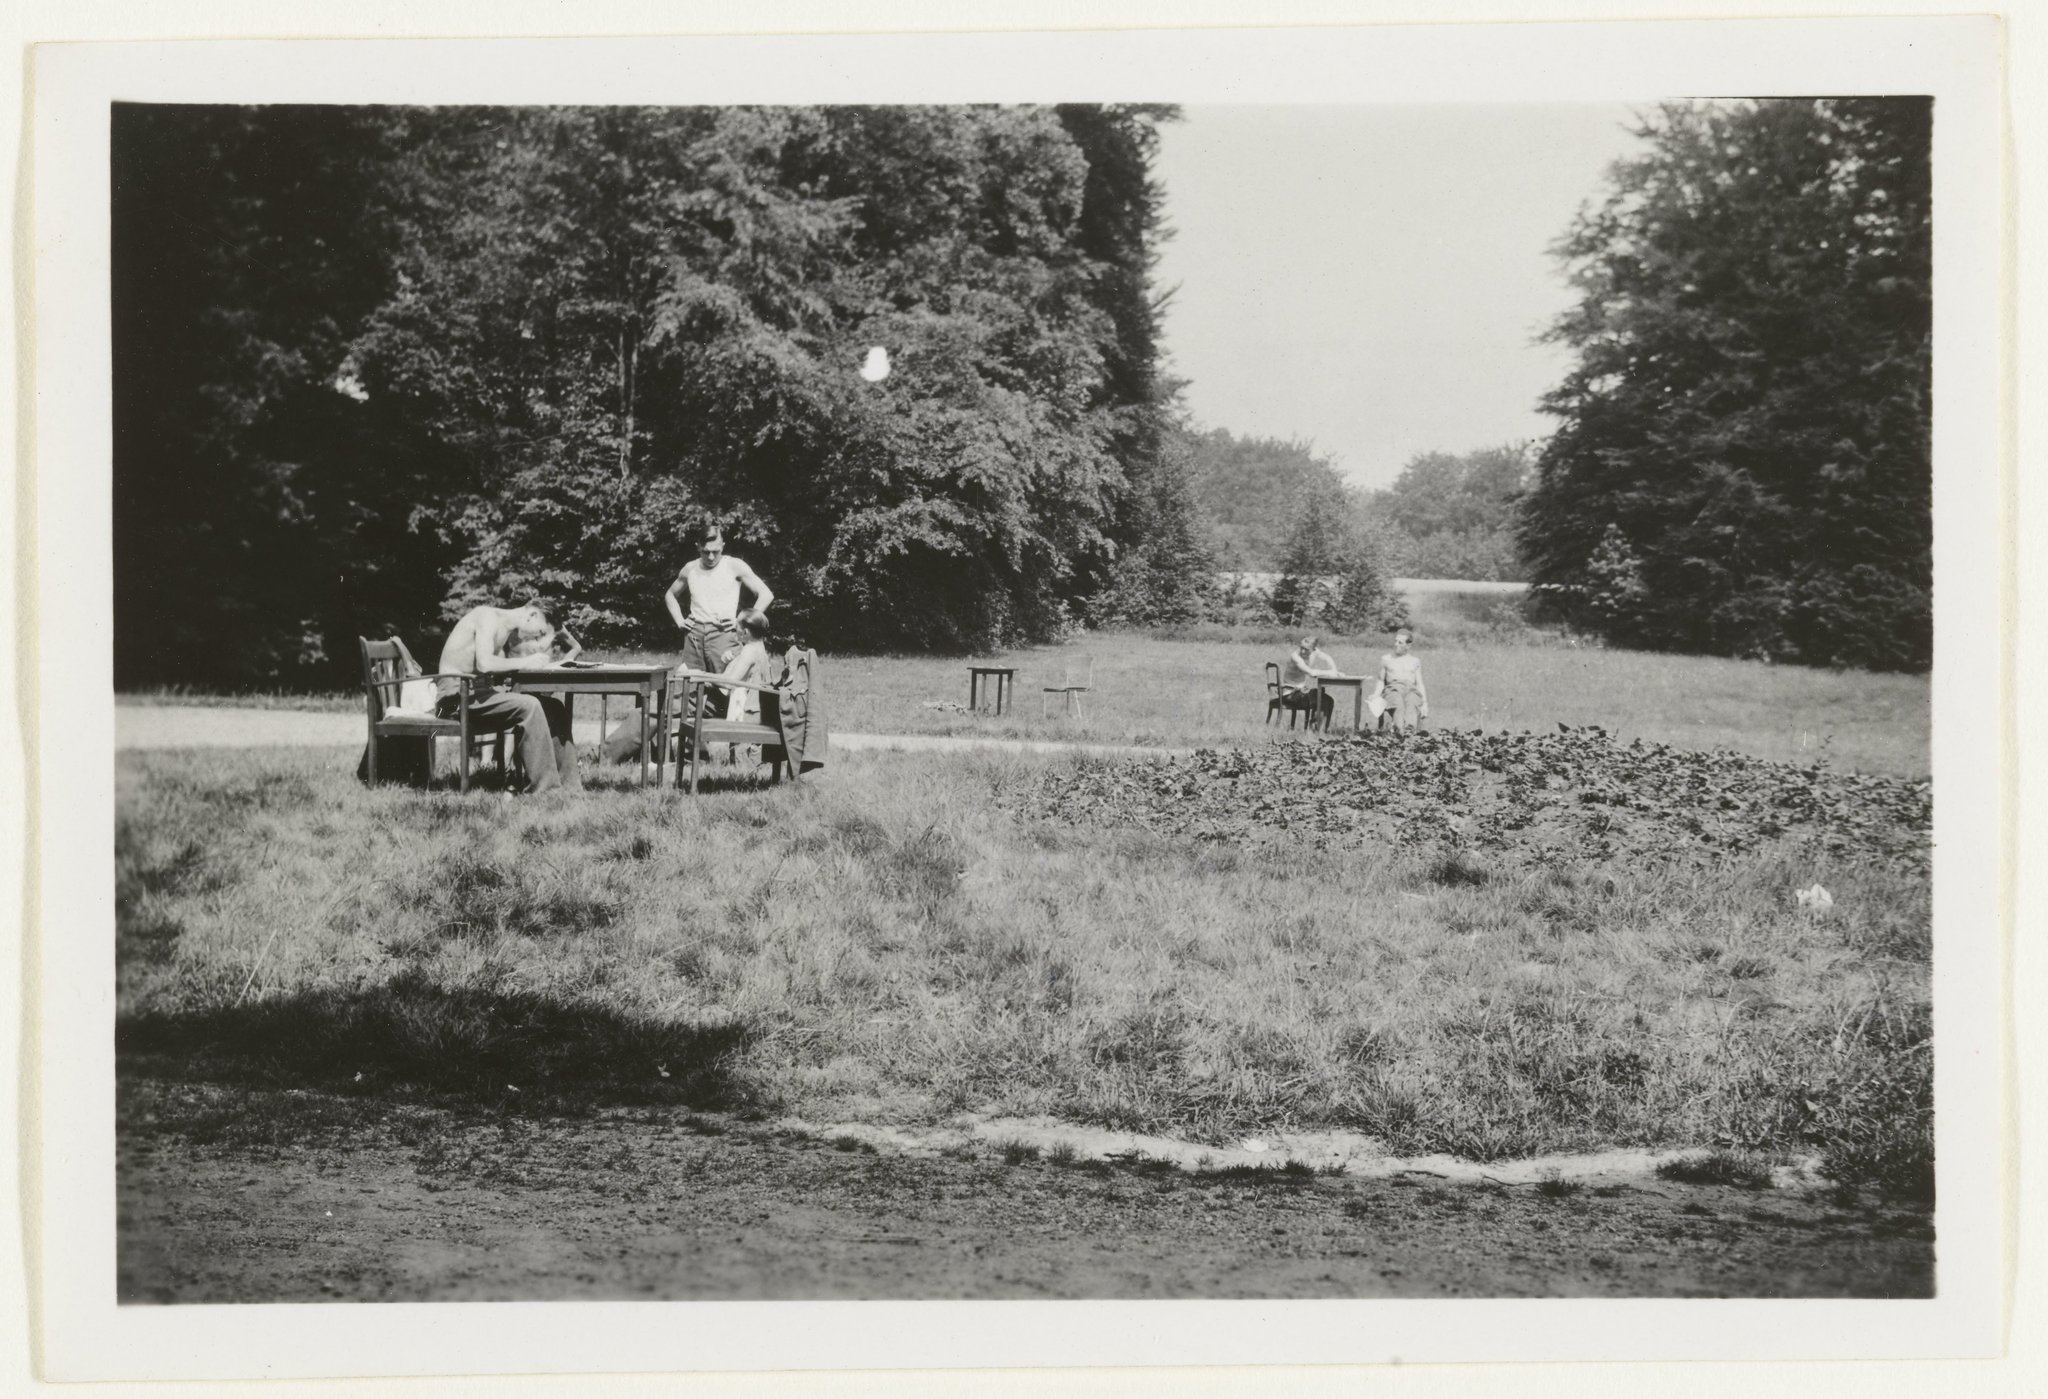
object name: photograph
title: Groep Duitse militairen aan een tafel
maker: Anonymous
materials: photographic support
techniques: gelatin silver print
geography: netherlands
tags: recreation ~ the soldier off duty, occupation ~ war, netherlands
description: Aan twee tafels op een grasveld omringd door bomen zitten Duitse militairen, sommige met bloot bovenlijf.